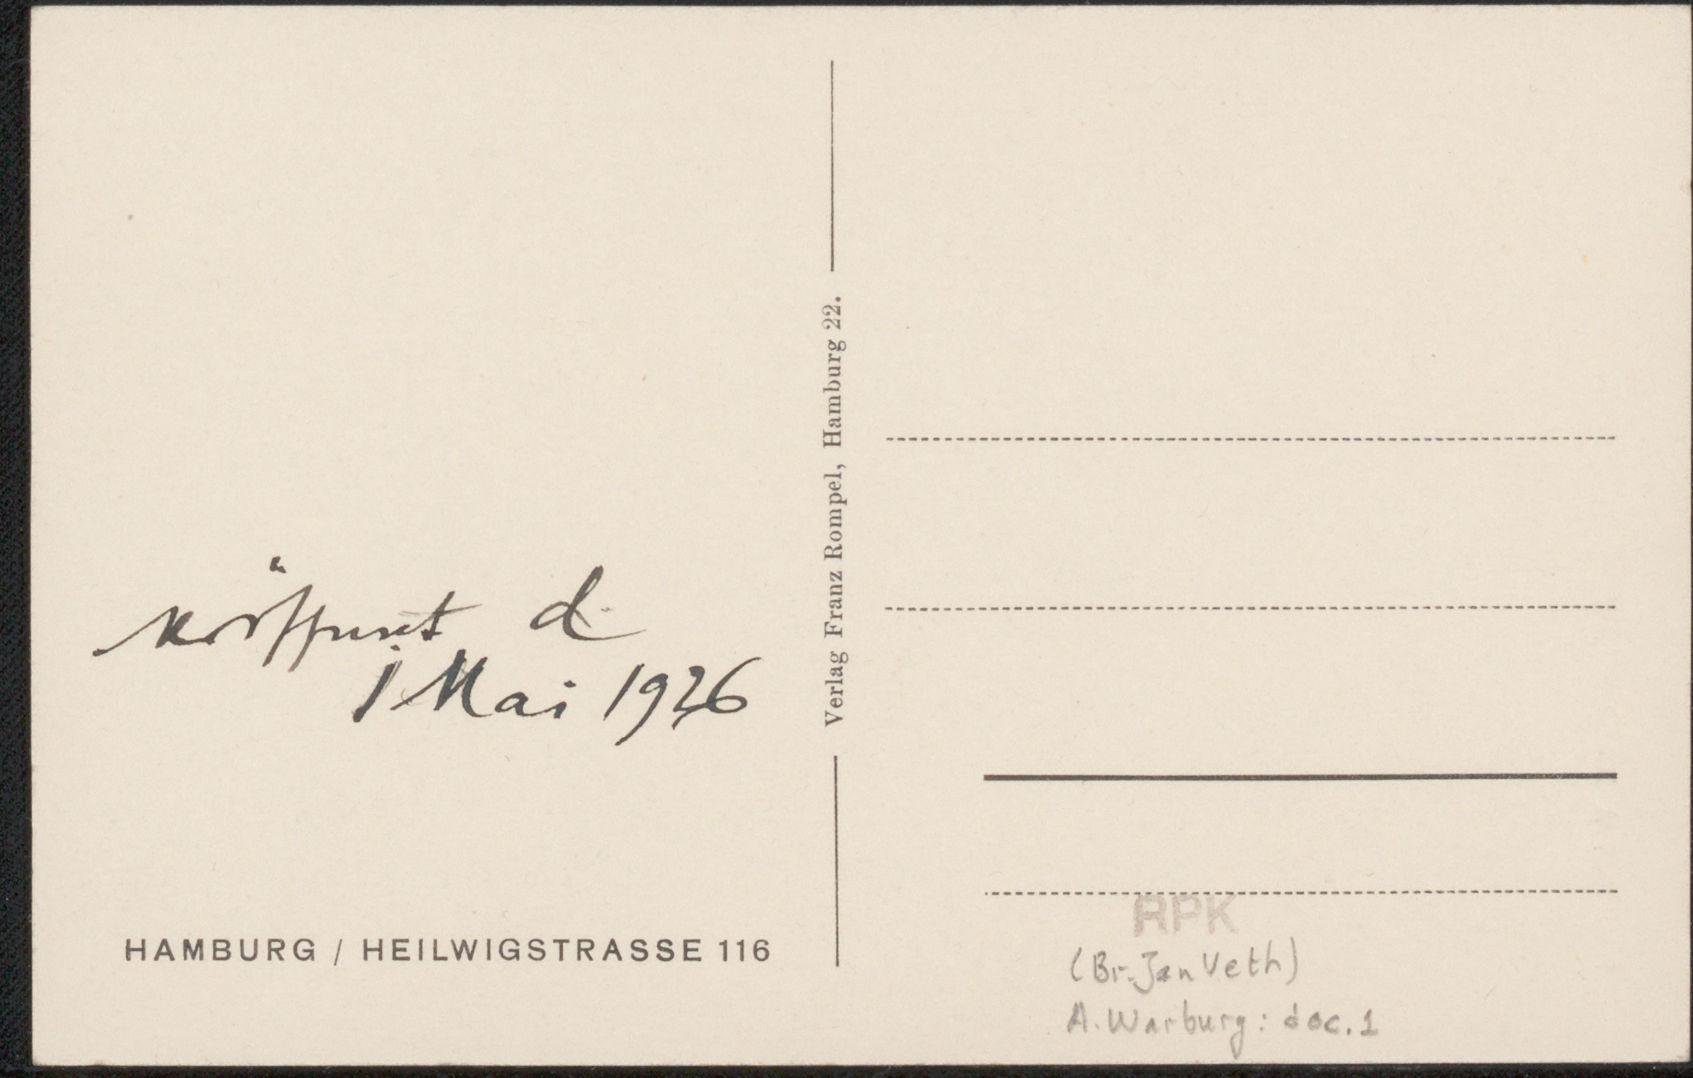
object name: ansichtkaart, prentbriefkaart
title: Prentbriefkaart uit archief Jan Veth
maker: aby warburg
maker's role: amateurfotograaf, kunsthistoricus, kunsttheoreticus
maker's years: 1866-1929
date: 1926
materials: cardboard, ink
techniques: pen, rotogravure, writing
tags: painter, print maker, draughtsman, designer, jan veth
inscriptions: collector's mark: ‘RPK’